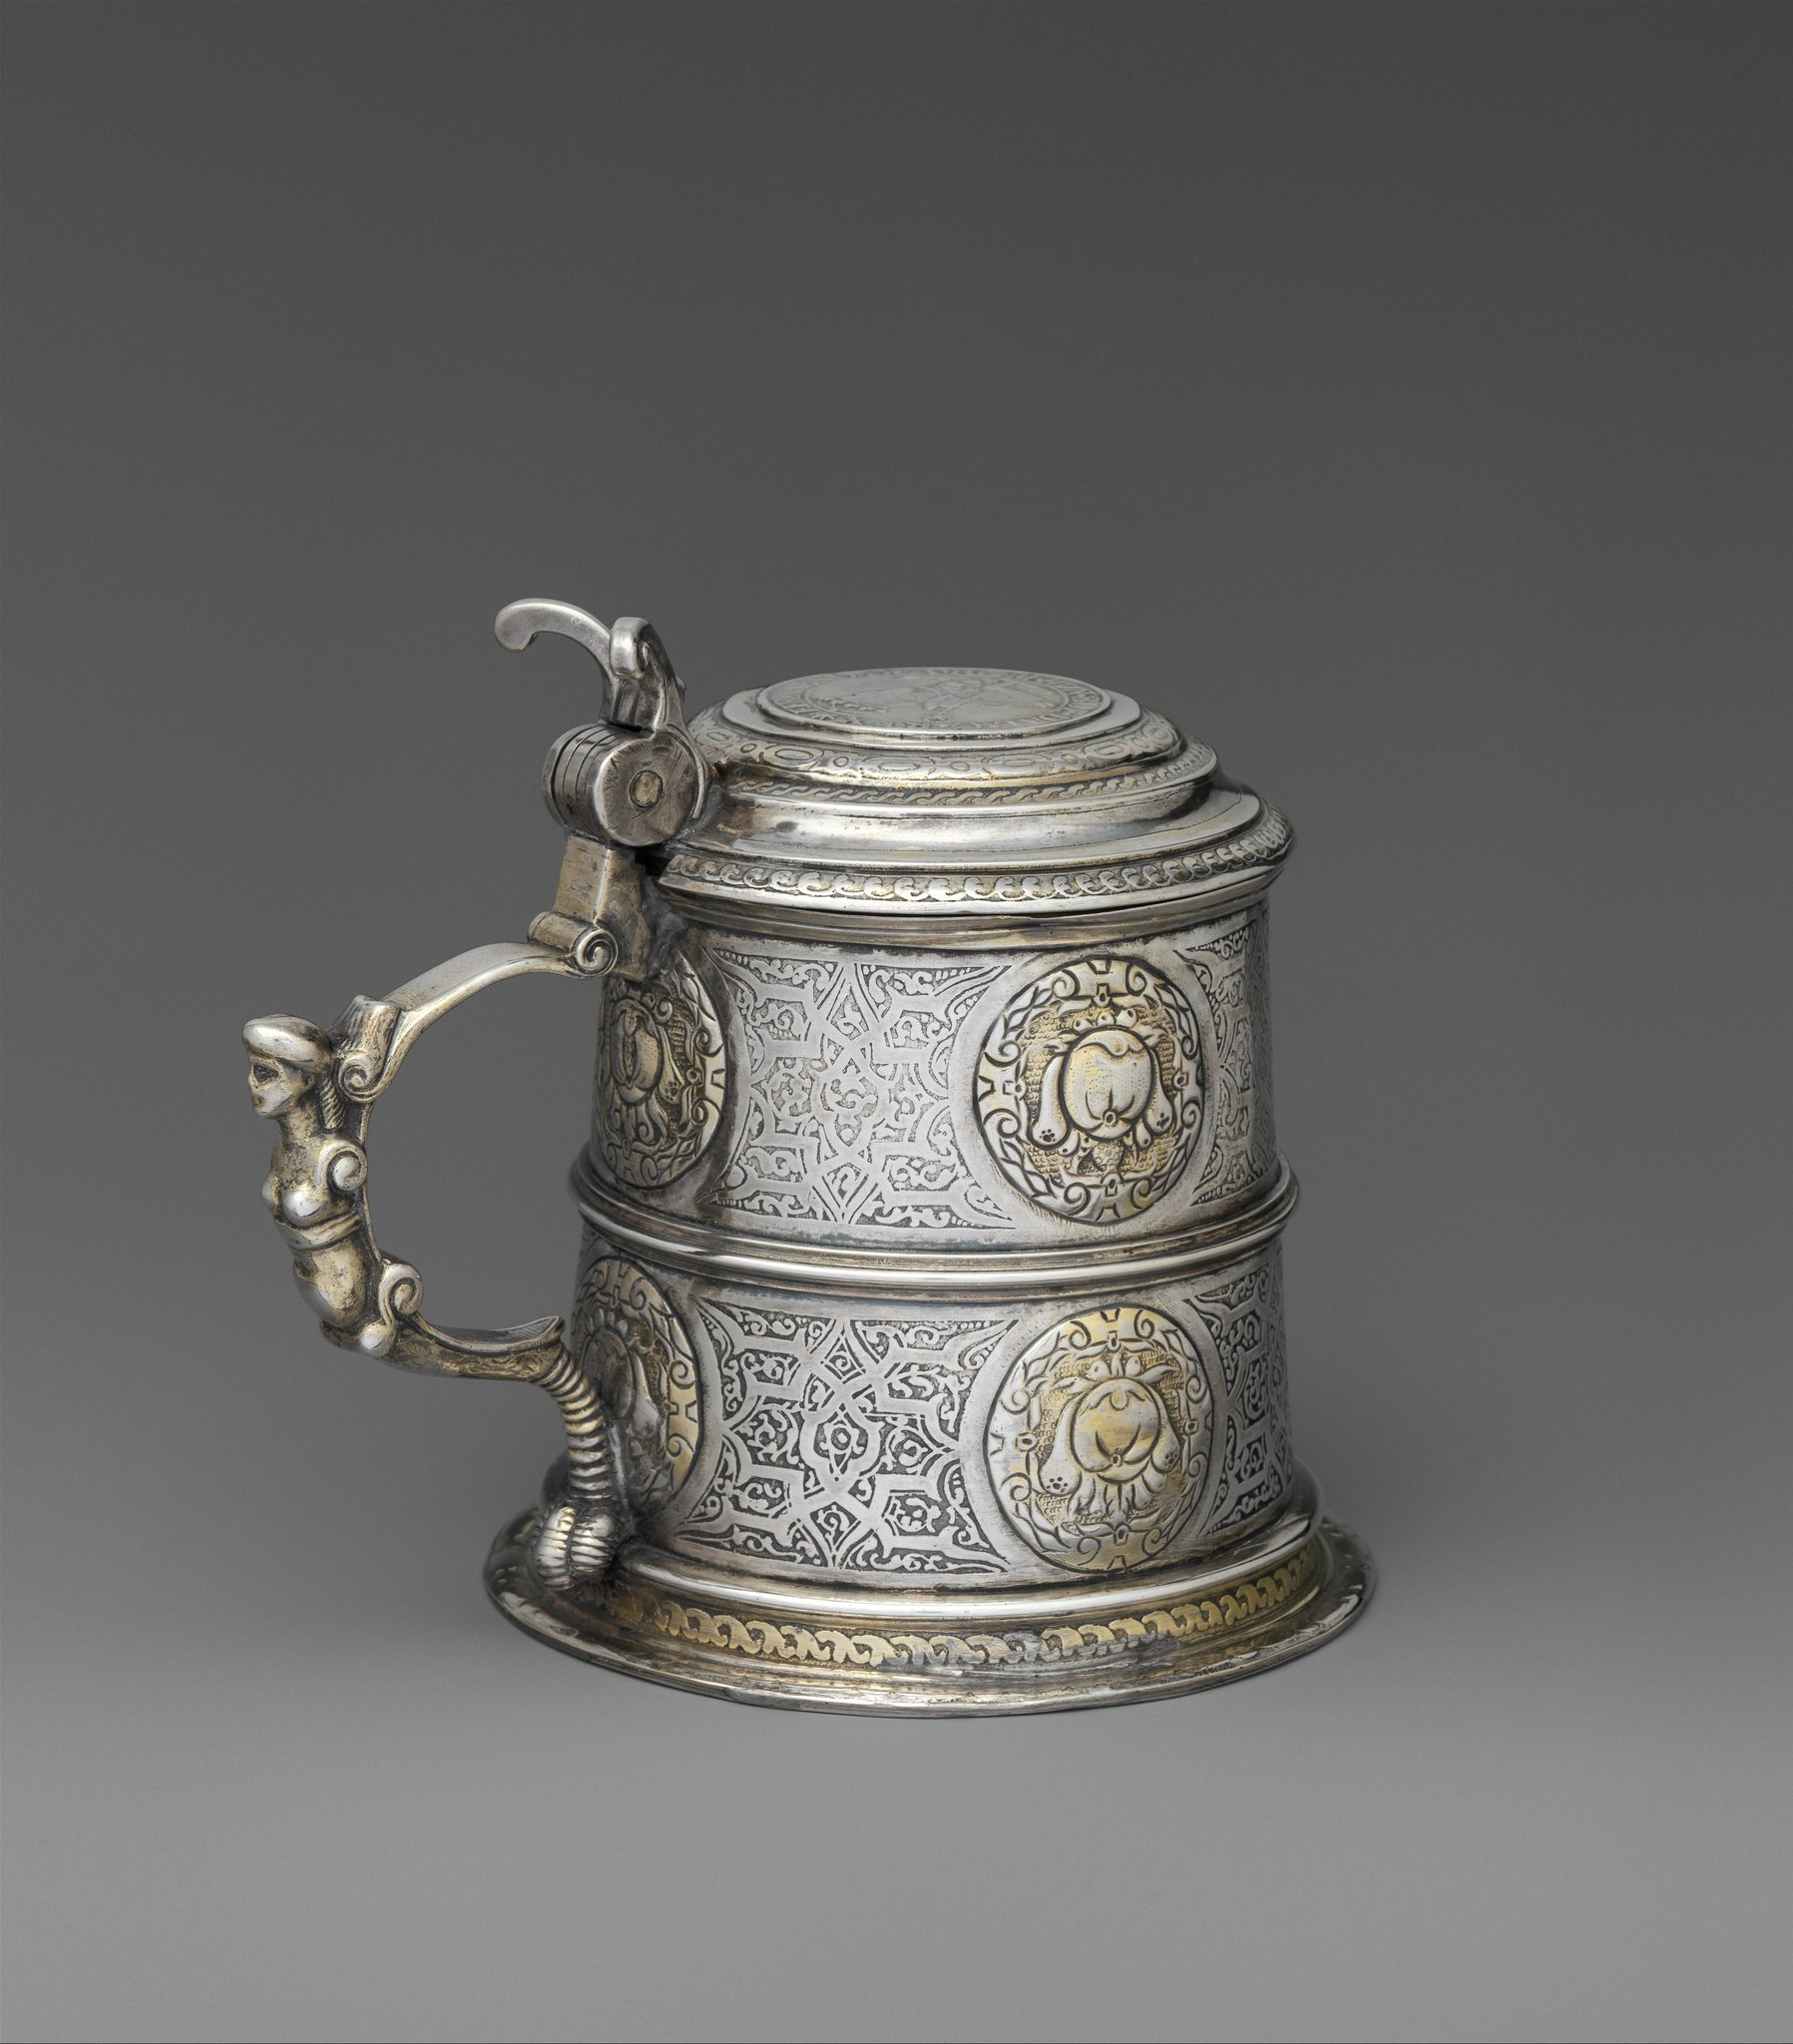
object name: tankard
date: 1567-1600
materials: silver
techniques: gilding